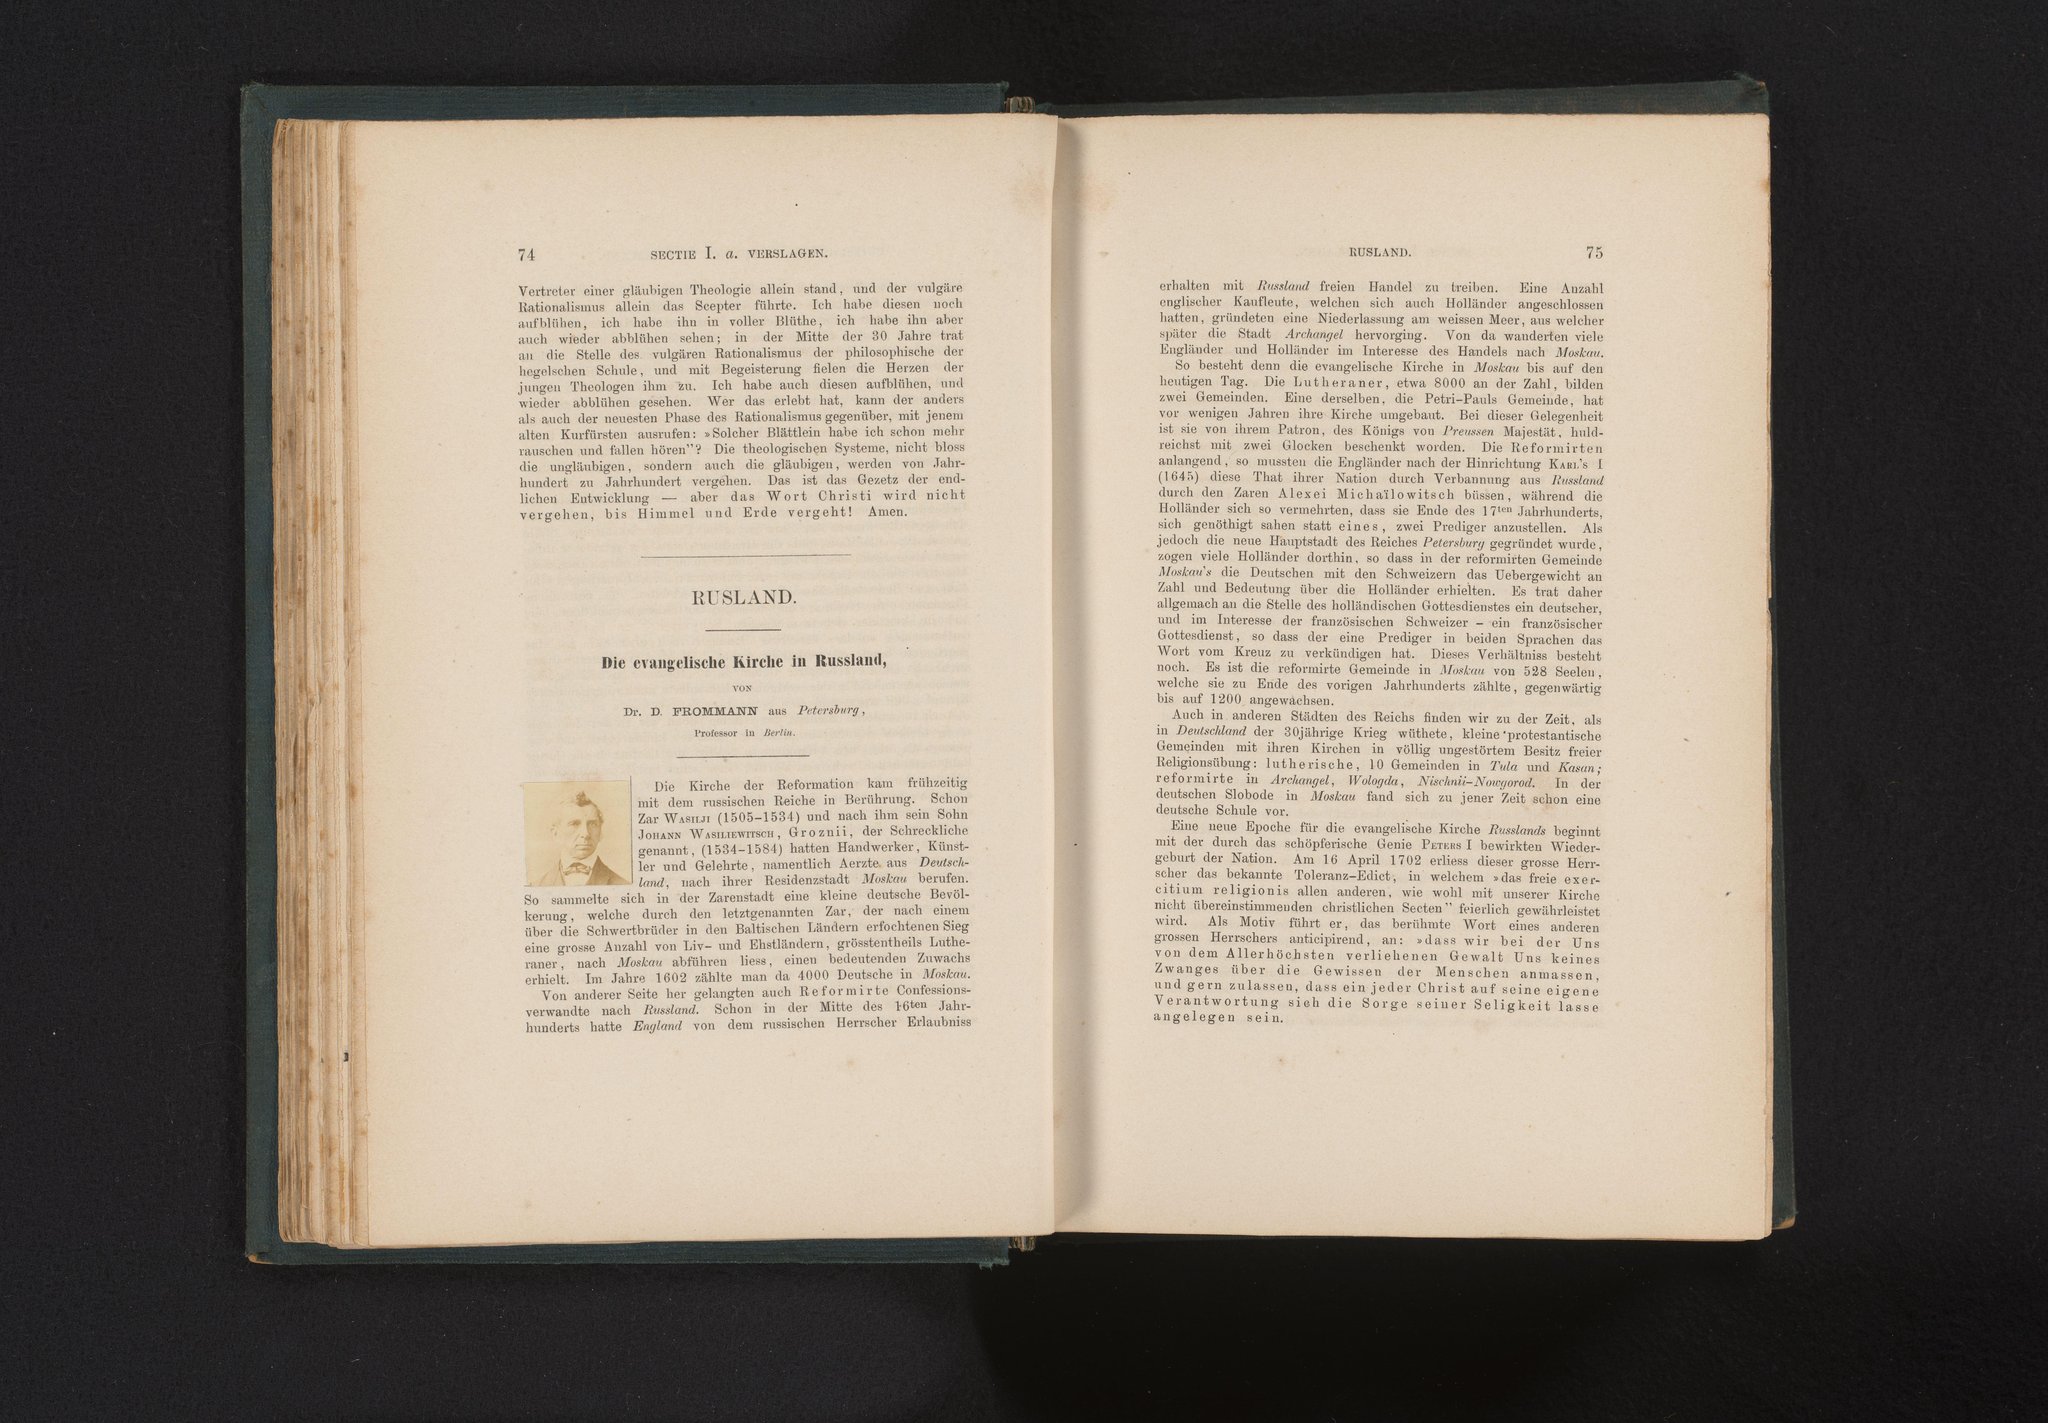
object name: photograph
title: Portret van professor D. Frommann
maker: Anonymous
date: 1855-1867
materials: paper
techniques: albumen print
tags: historical persons